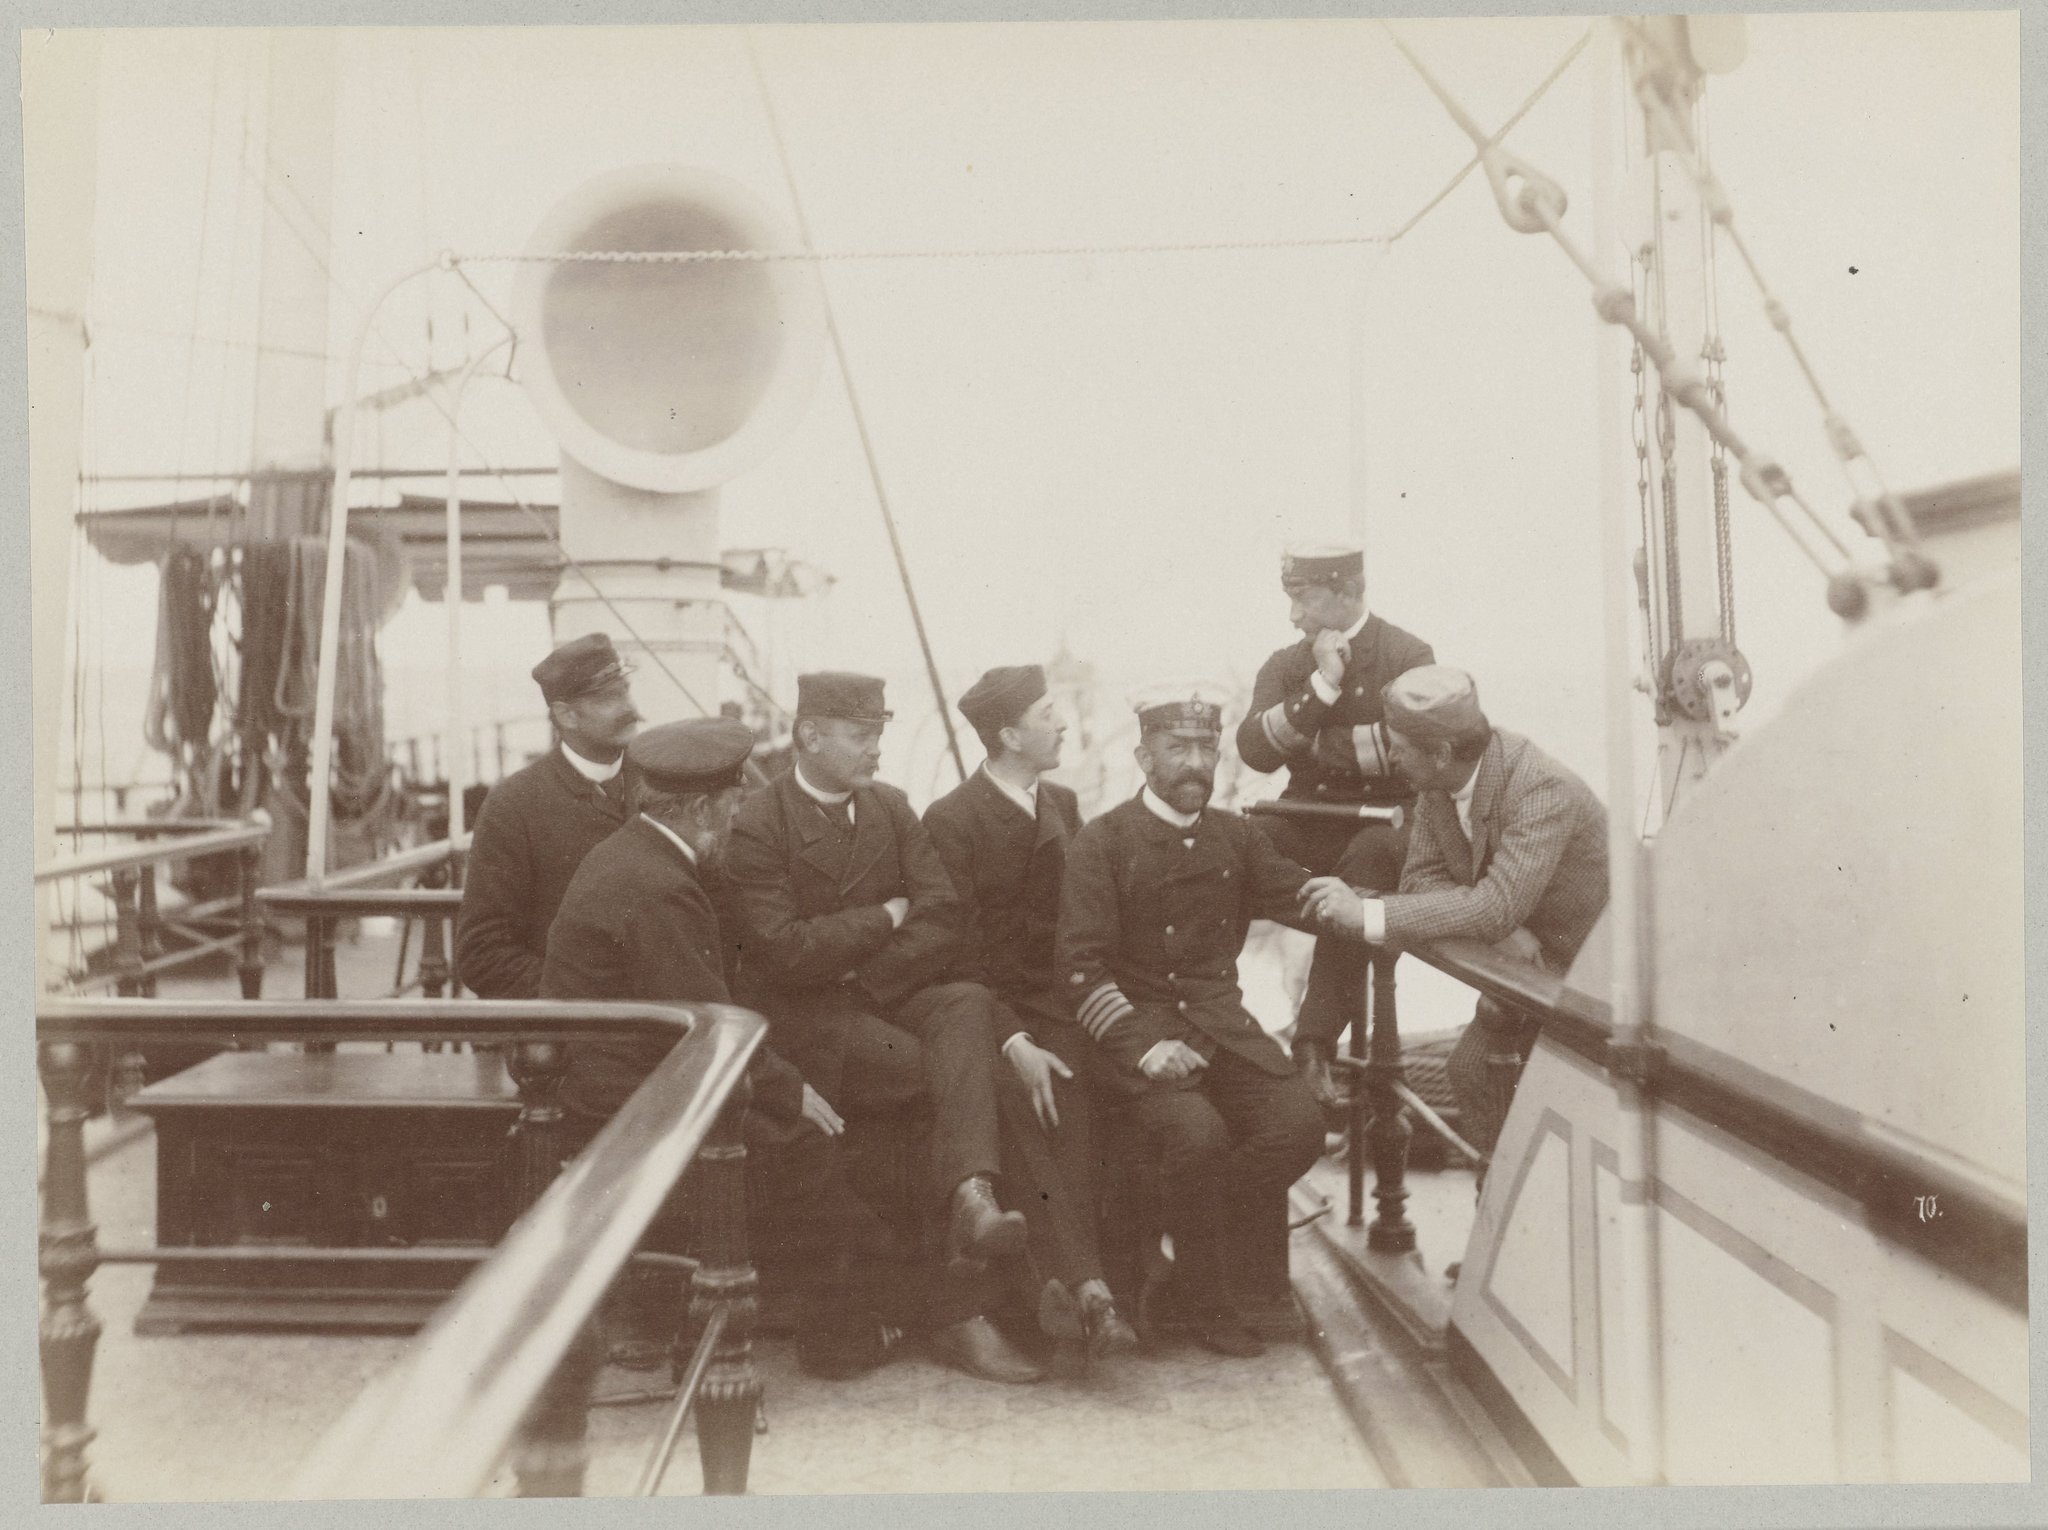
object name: photograph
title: Ernste Unterhaltung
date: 1807-1889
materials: cardboard, paper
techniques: albumen print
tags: wilhelm ii (keizer van duitsland), norway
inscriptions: number: ‘36’, number: ‘70’